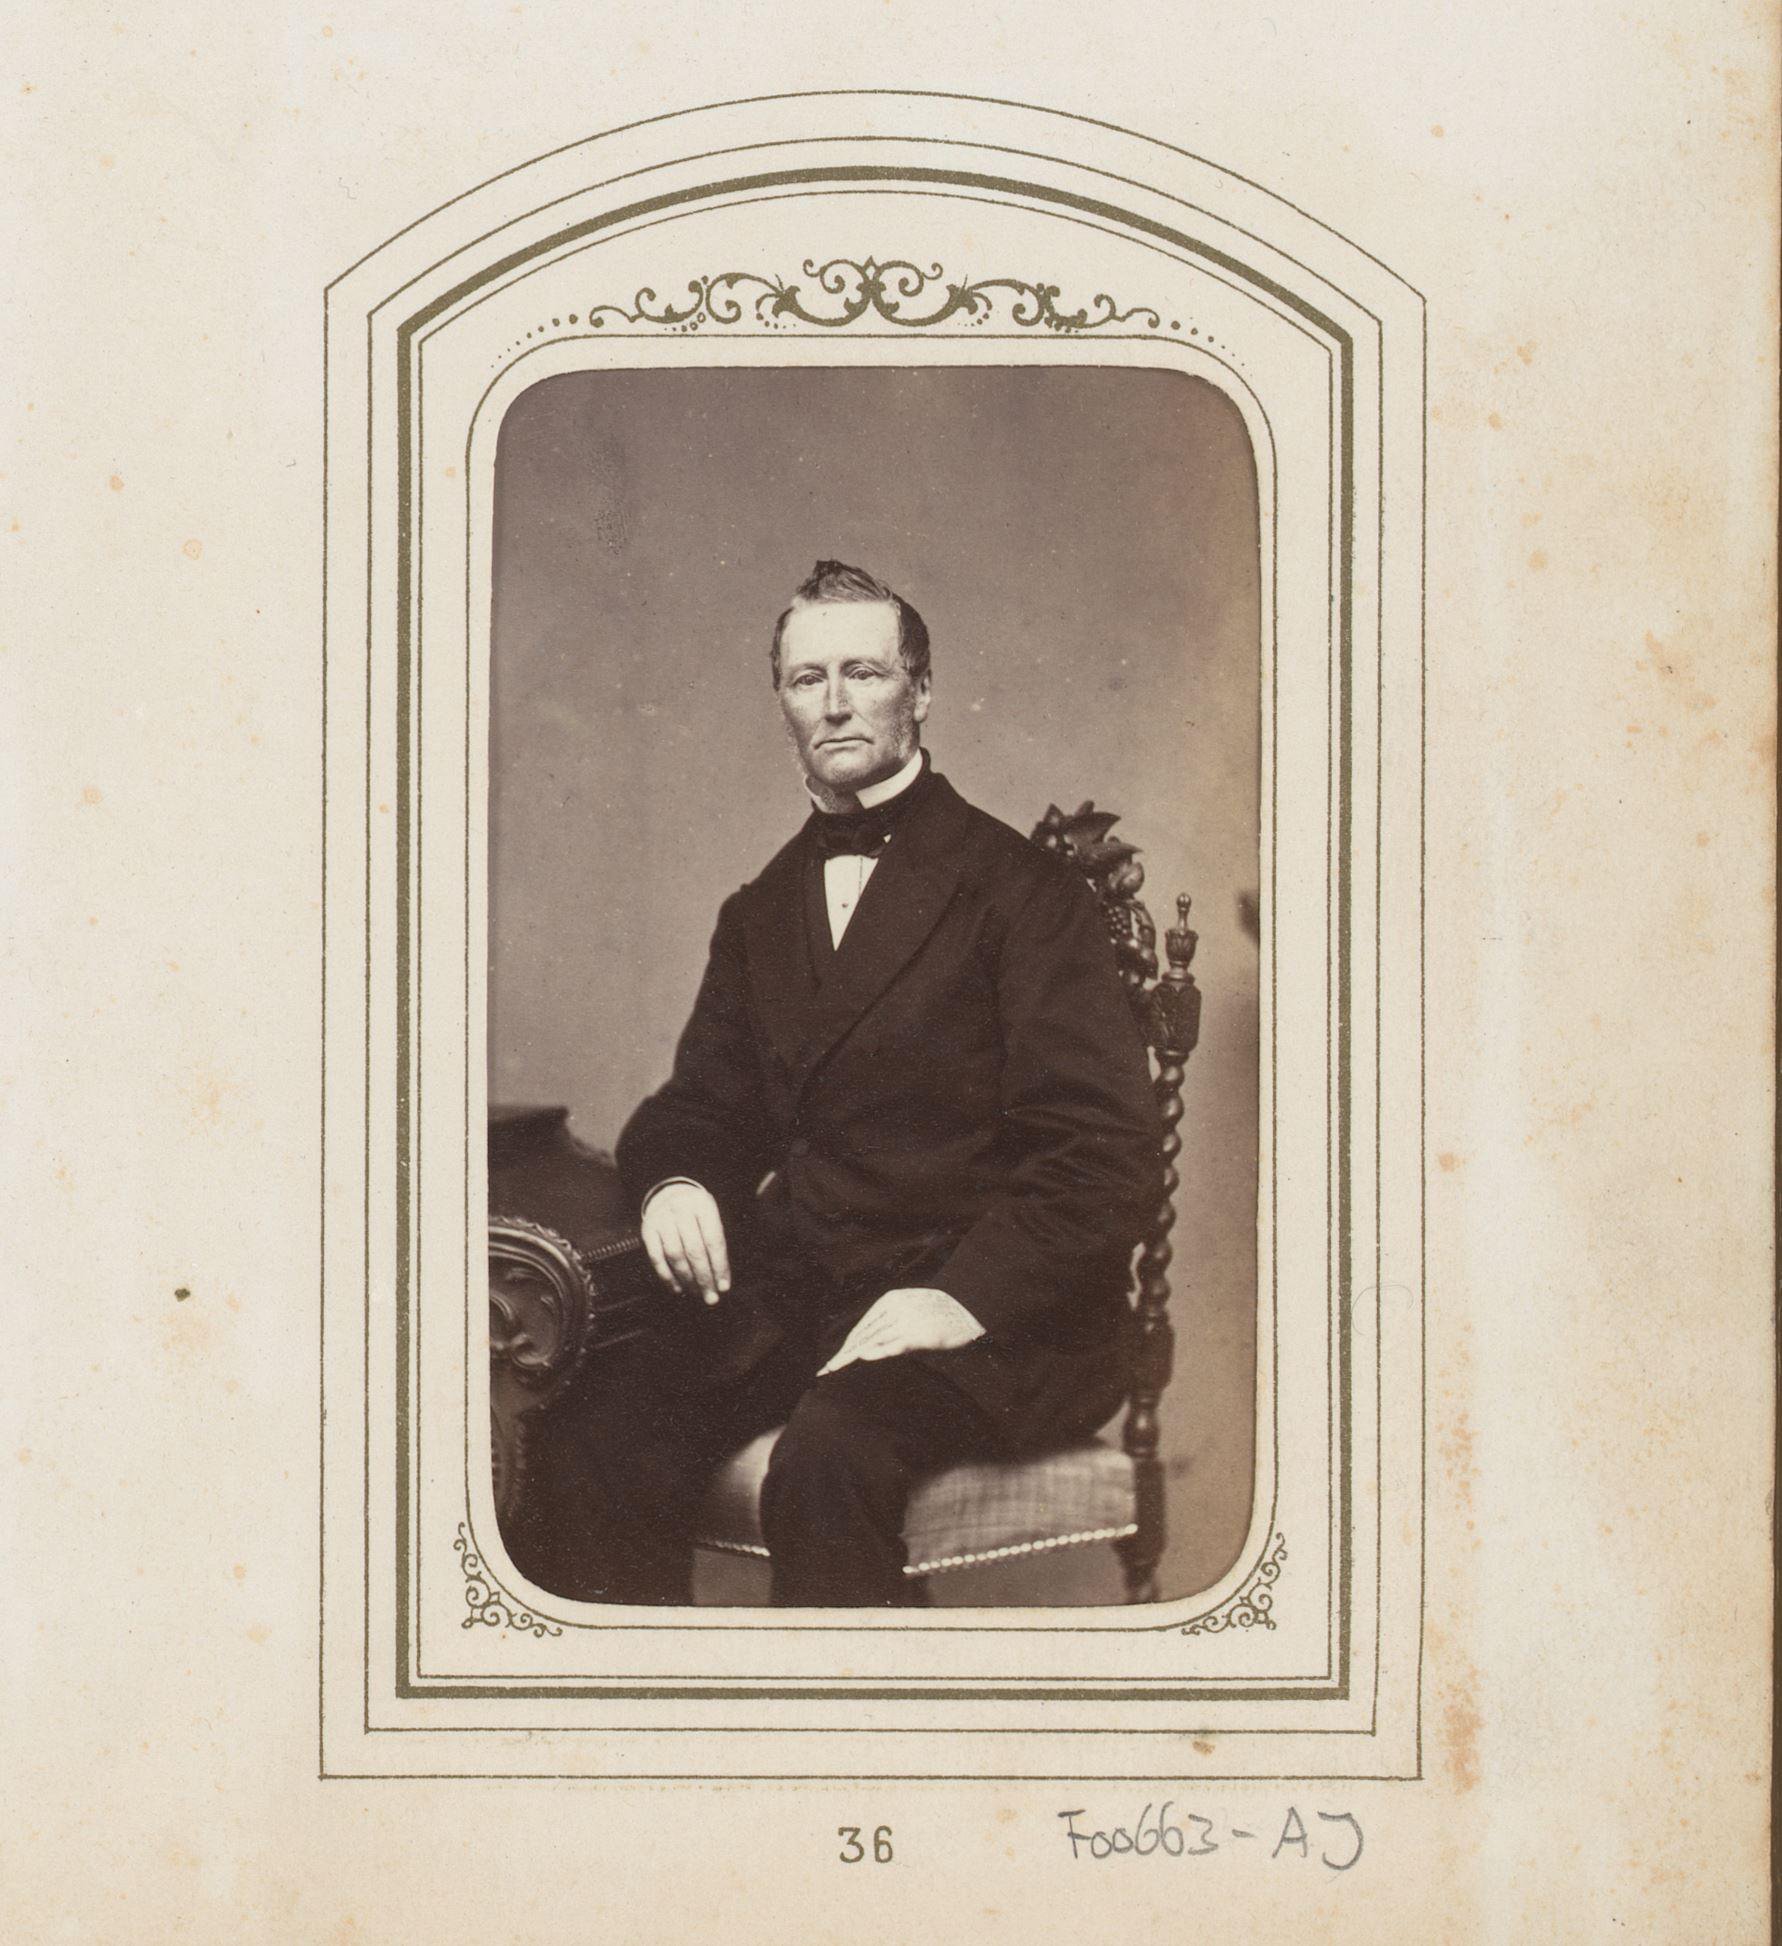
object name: carte de visite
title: Portret van een zittende man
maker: eduard fuchs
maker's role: painter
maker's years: 1832-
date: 1859-1870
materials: cardboard, photographic support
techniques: albumen print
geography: leeuwarden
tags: historical persons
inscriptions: number: ‘36’, inscription: ‘Photographie/ E. Fuchs/ Leeuwarden’